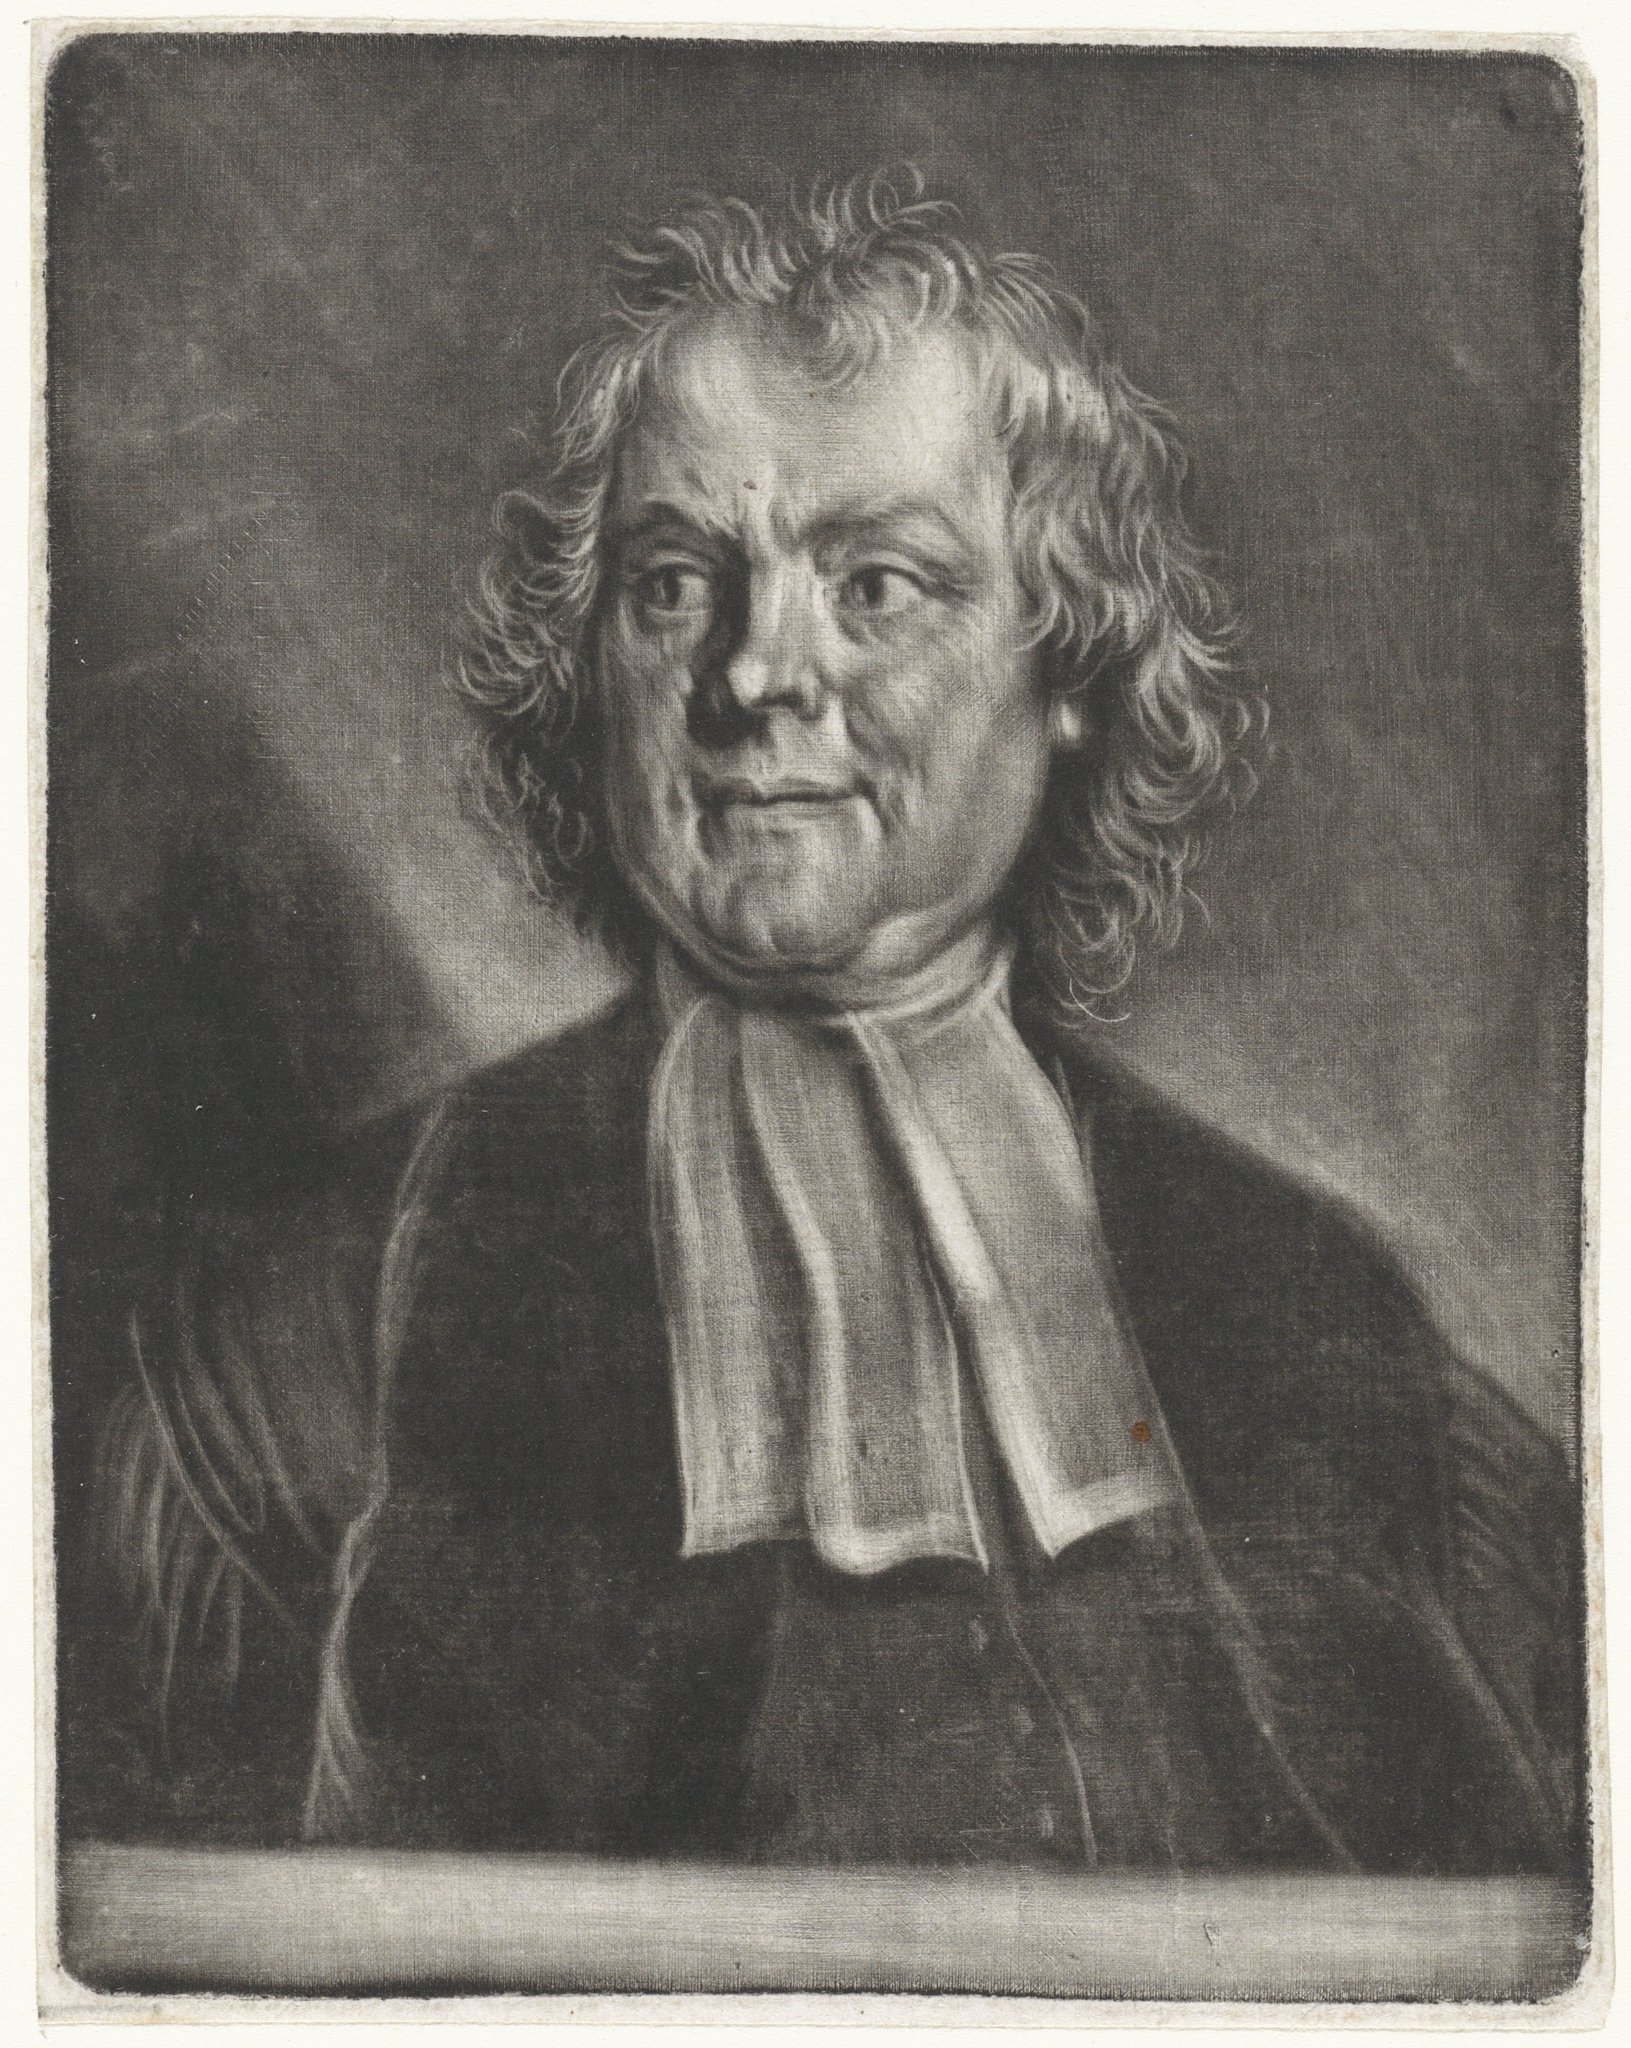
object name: print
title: Portret van Hermanus Boerhaave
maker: Anonymous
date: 1735-1800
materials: paper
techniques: mezzotint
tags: leiden, hermanus boerhaave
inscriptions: collector's mark: Lugt 240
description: Hermanus Boerhaave, geneeskundige en hoogleraar aan de universiteit te Leiden. Hij draagt een vierkante kraag.